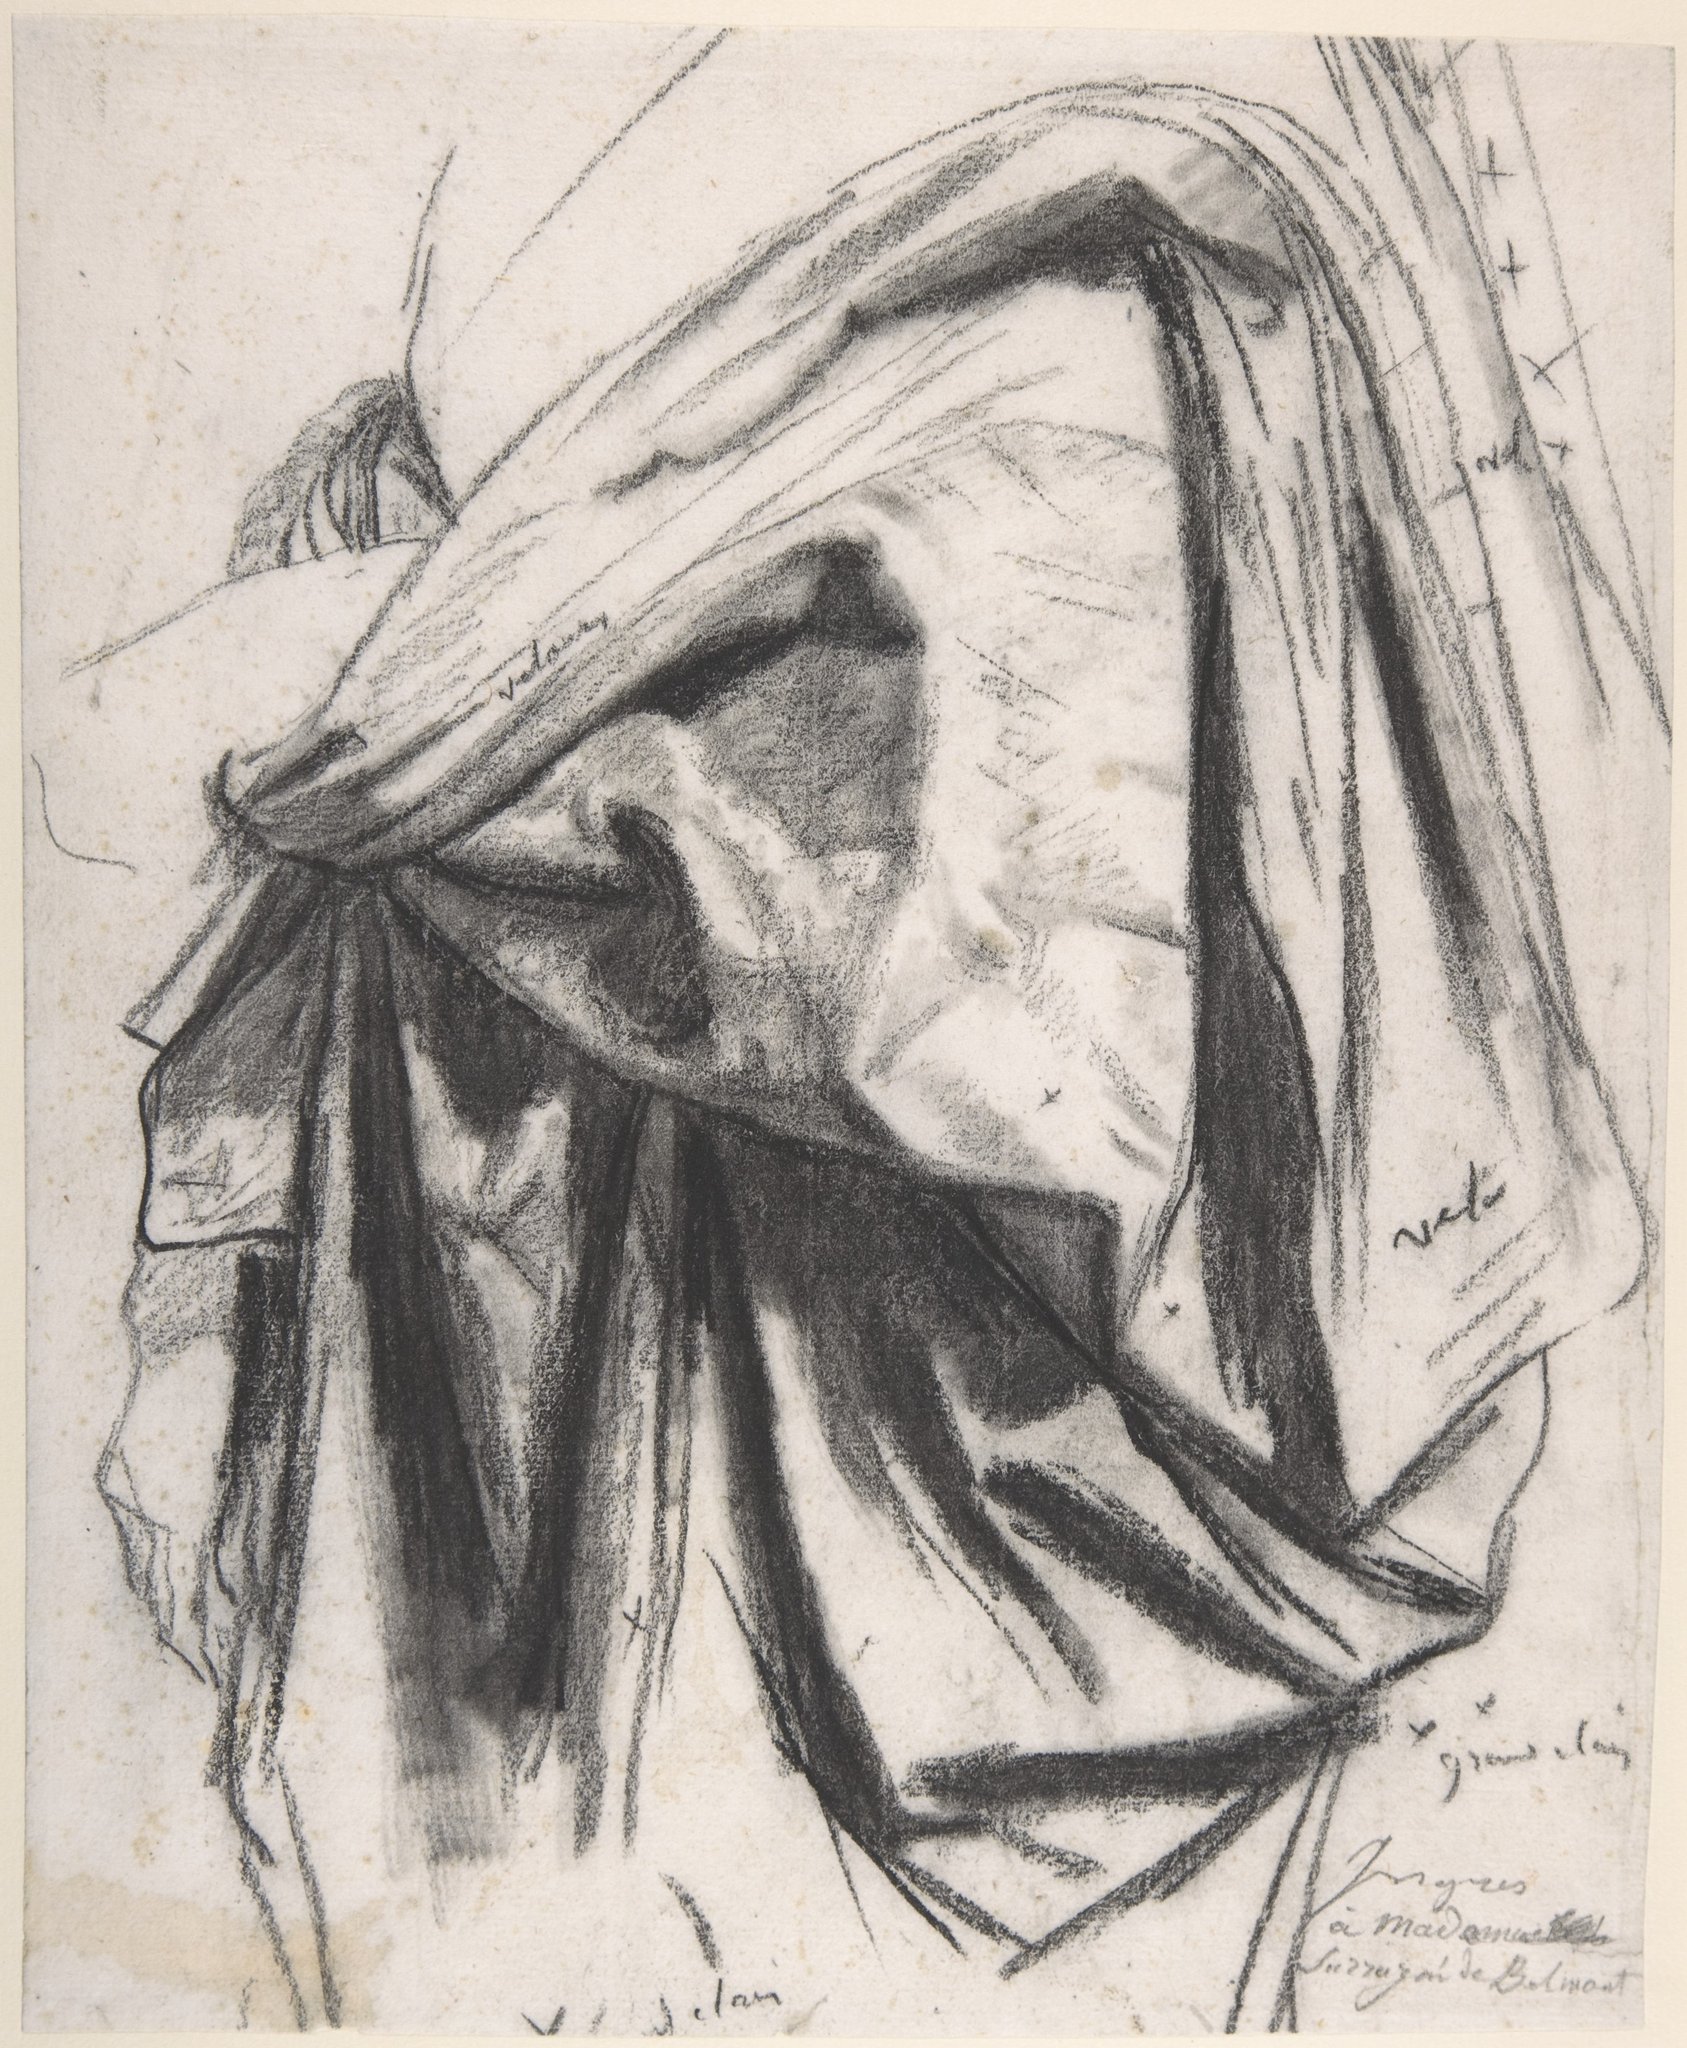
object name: drawing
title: Study for the Drapery of Molière in "The Apotheosis of Homer"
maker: jean auguste dominique ingres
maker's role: artist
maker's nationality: french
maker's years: 1780-1867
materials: chalk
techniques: stumping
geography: france